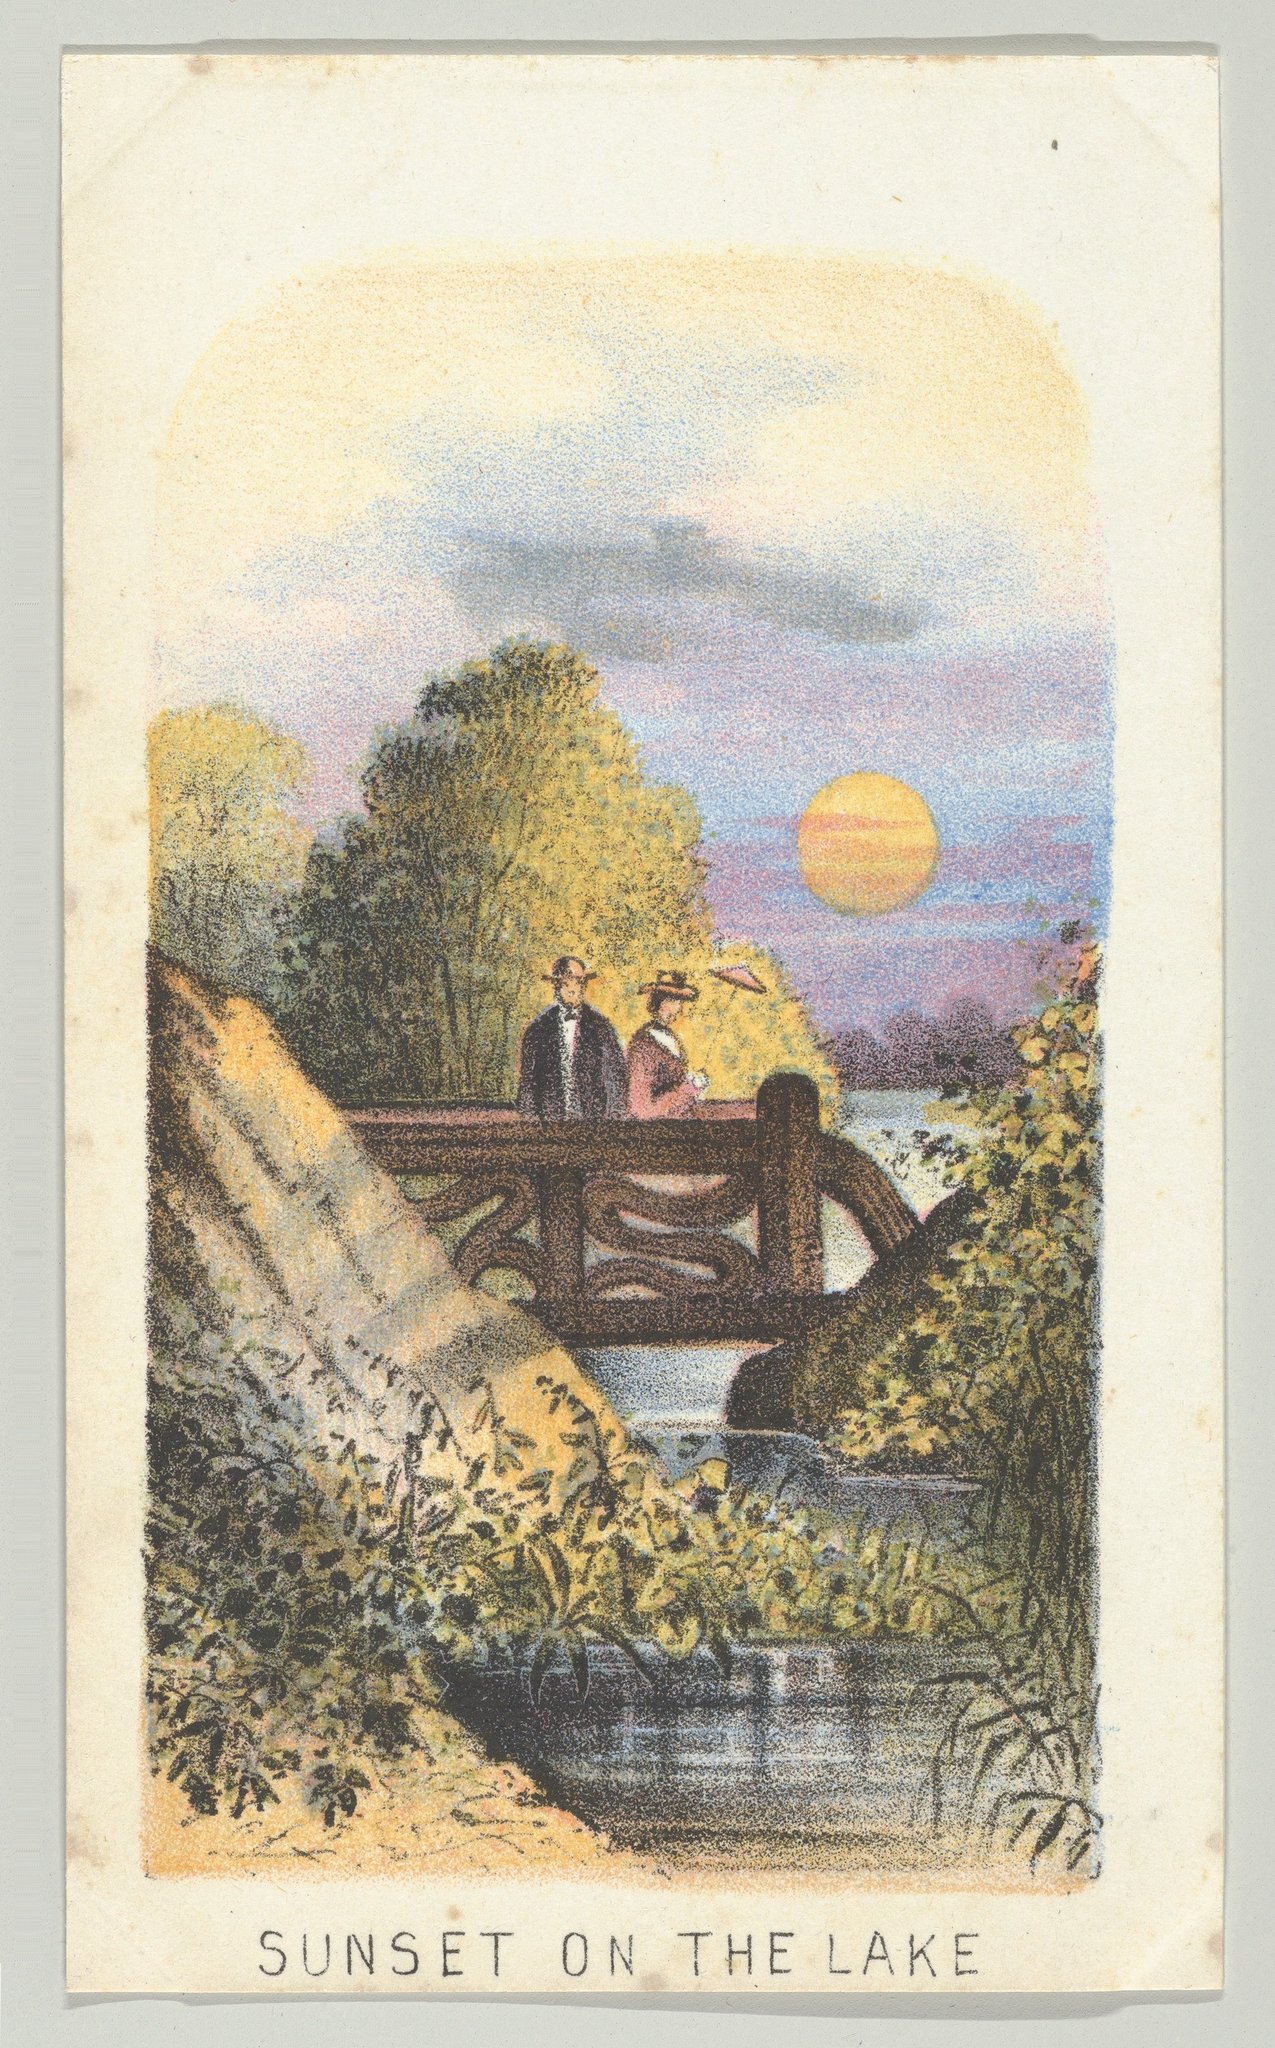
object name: print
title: Sunset on the Lake, from the series, Views in Central Park, New York, Part 2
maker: louis prang & co.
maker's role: publisher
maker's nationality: american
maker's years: 1800-1950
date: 1864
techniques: lithograph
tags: men,women,sun,landscapes,evening